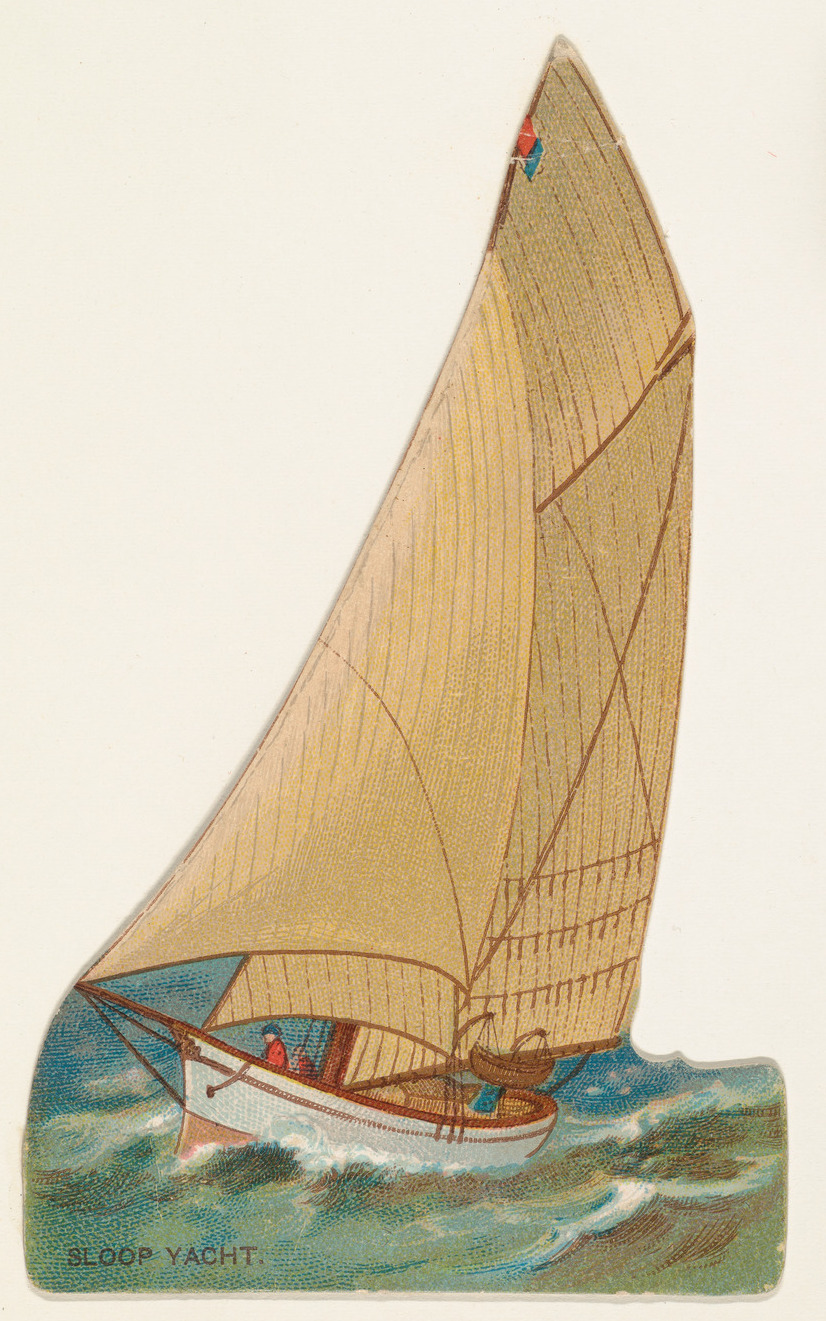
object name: print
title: Sloop Yacht, from the Types of Vessels series (N139) issued by Duke Sons & Co. to promote Honest Long Cut Tobacco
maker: w. duke, sons & co.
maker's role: publisher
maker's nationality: american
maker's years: 1870-1920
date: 1889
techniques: color lithograph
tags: boats